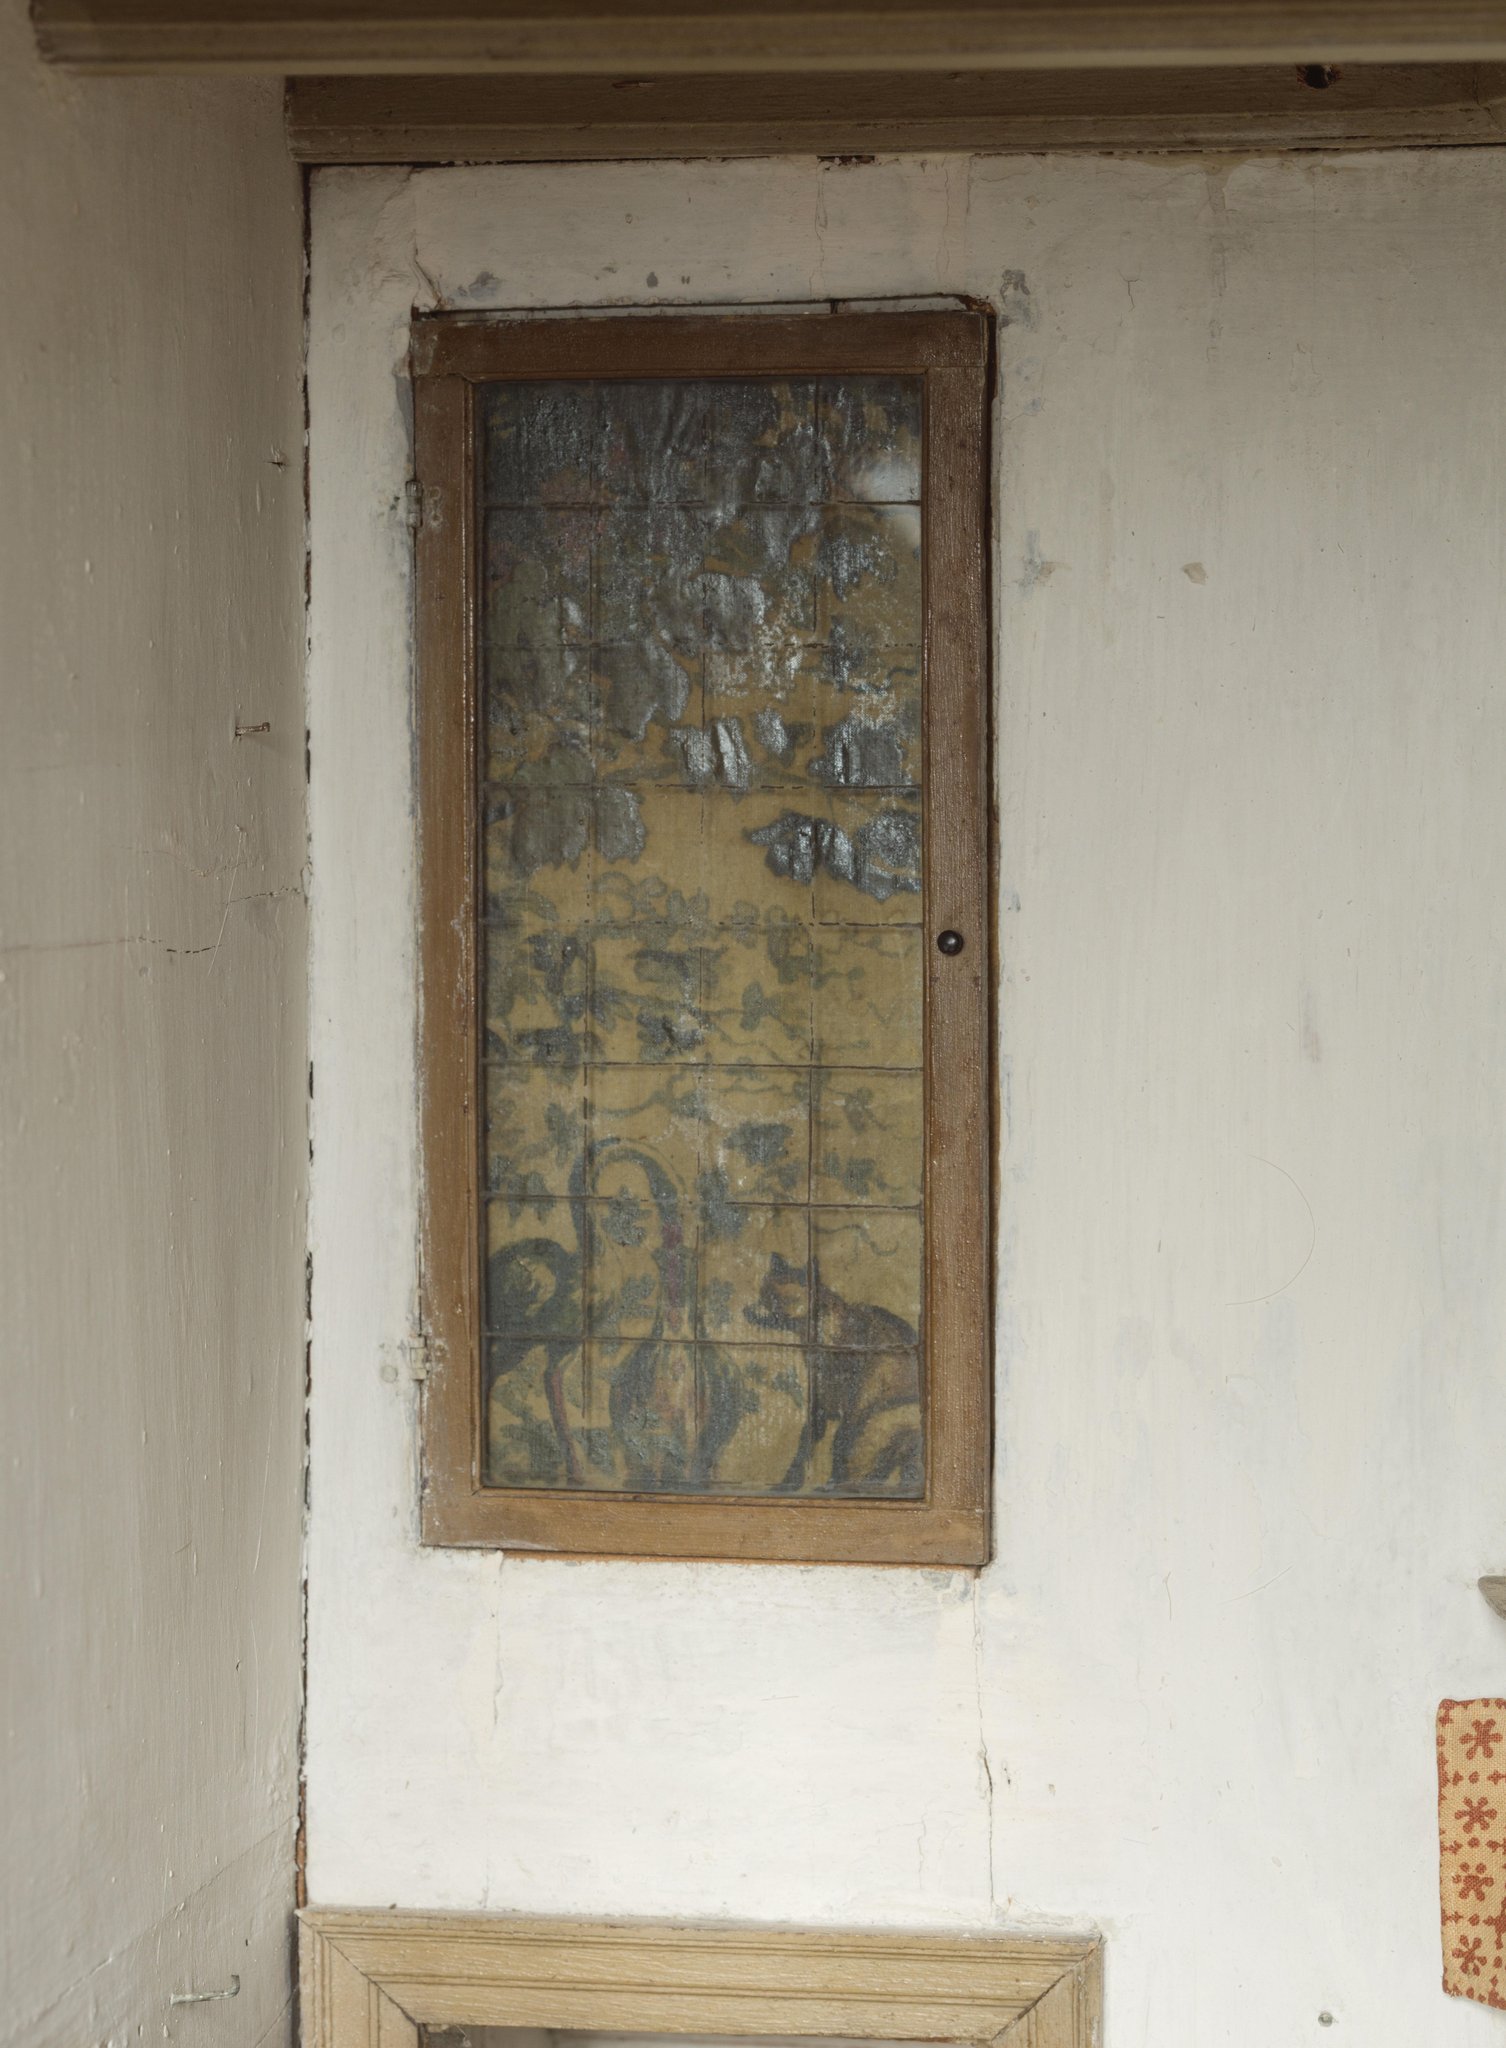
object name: storm window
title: Voorzetraam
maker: Anonymous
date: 1700-1710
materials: gouache, resin, silk, wood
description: Sassinet of beschilderde voorzetraam; vervaardigd uit een smal houten raamwerk, bespannen met crème-kleurige zijde die beschilderd is met druivenranken en een voorstelling uit de fabels van Aesopus: het verhaal van 'De vos en de Kraen'. De afbeelding is ontleend aan de illustratie van de betreffende fabel nr. VII uit Vondels 'Vorstelijke waronde der dieren', uitgave 1617.